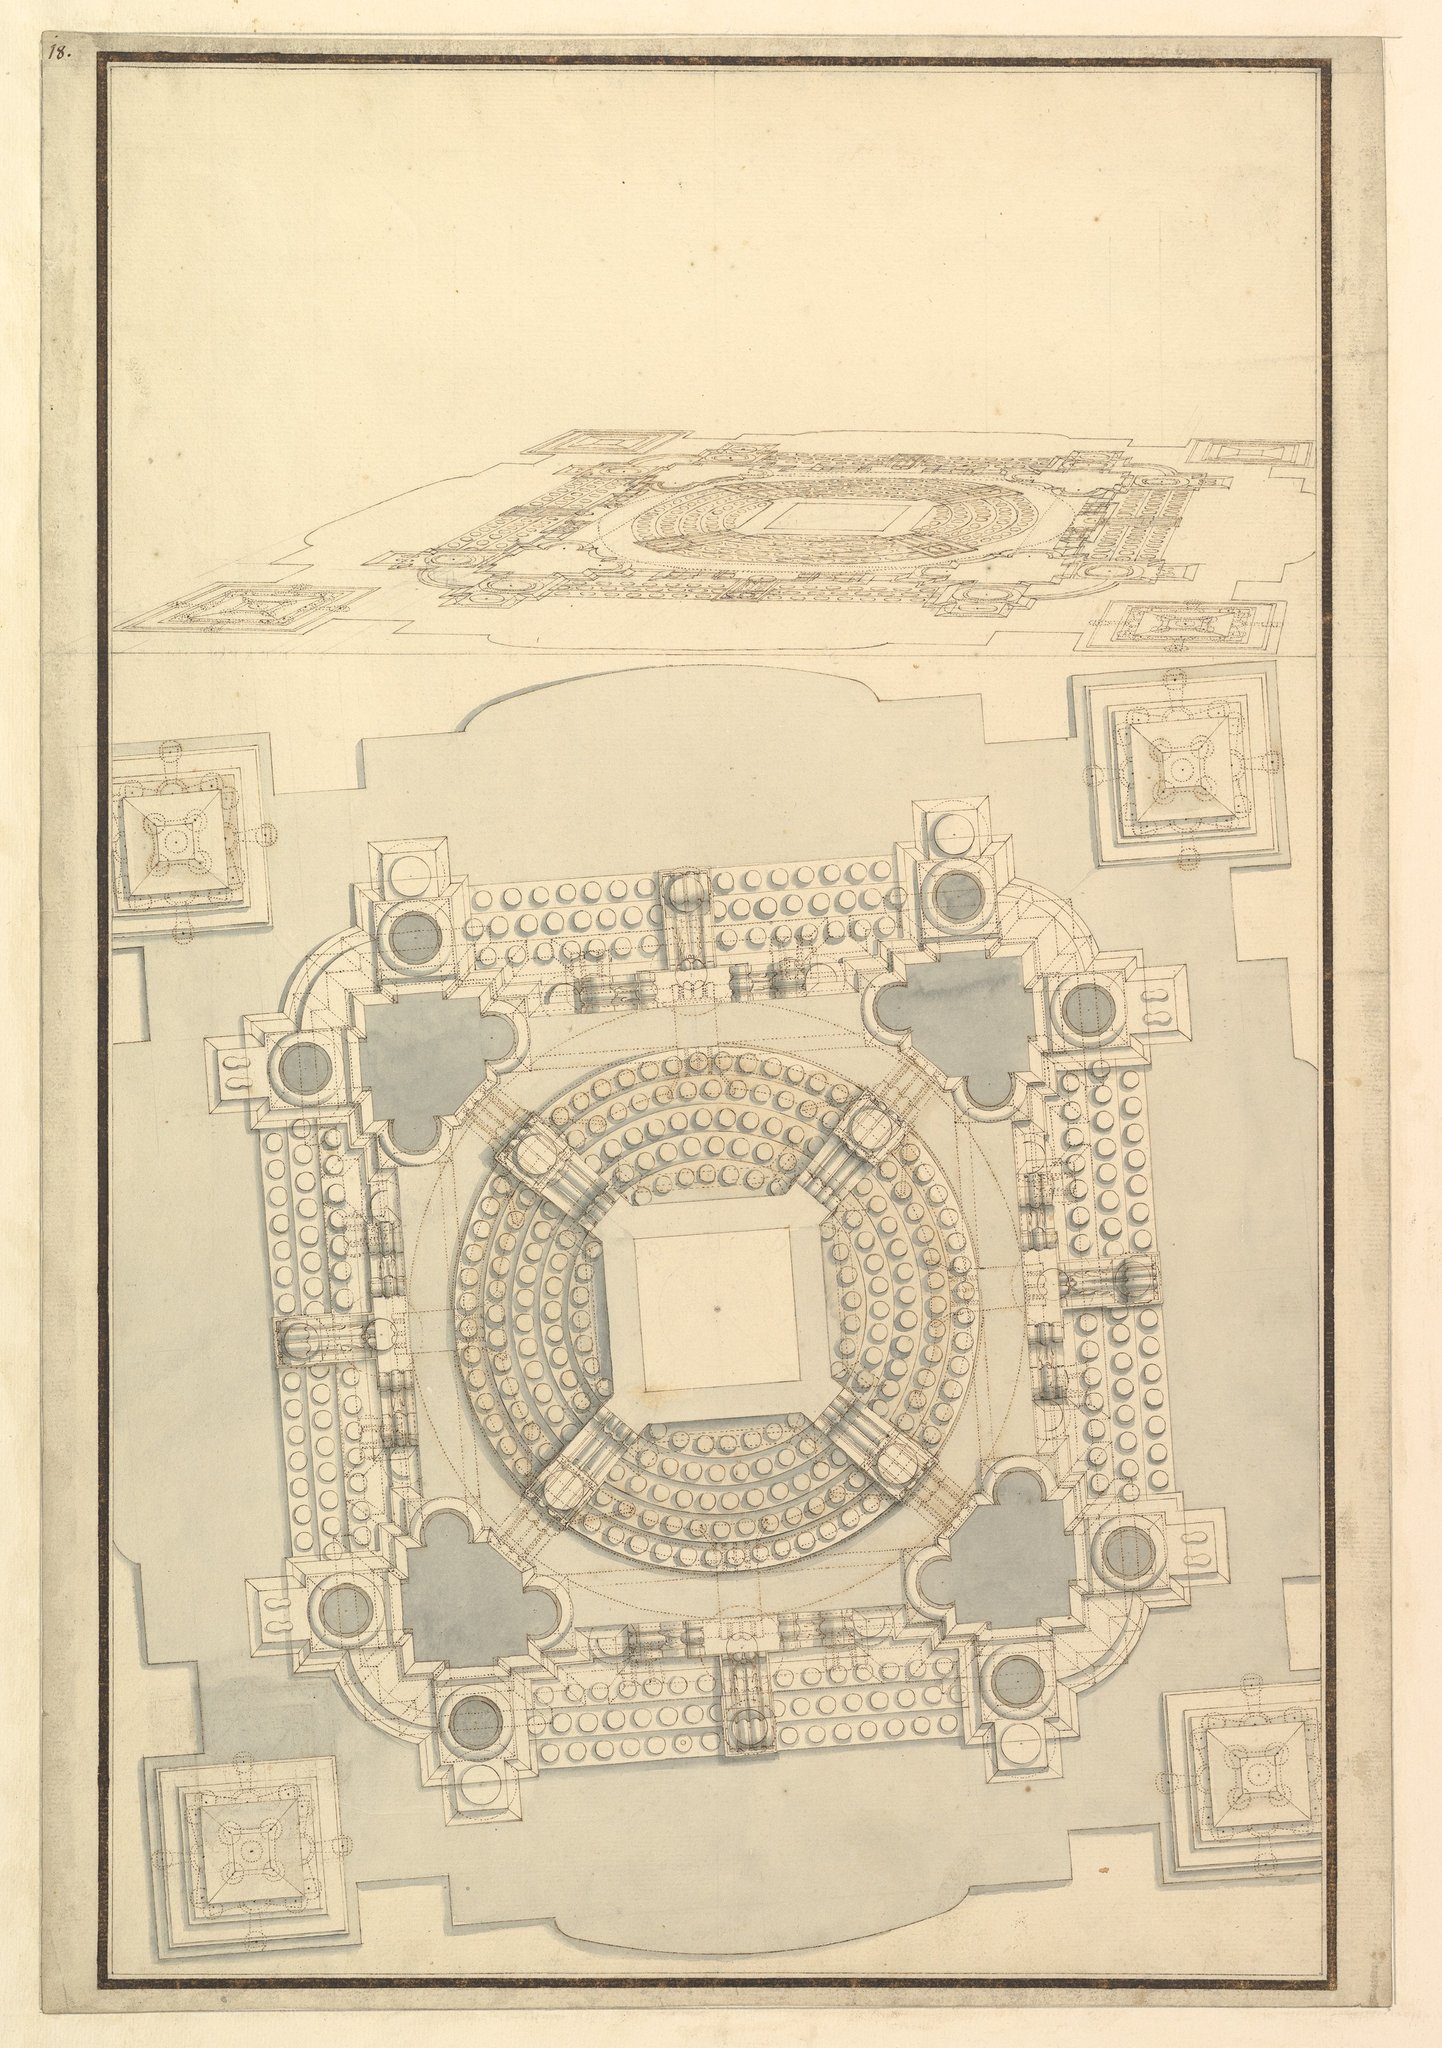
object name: drawing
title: Ground Plan of the Catafalque for Anna Cristina, Wife of Carlo Emanuele II of Savoy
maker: giuseppe galli bibiena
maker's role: artist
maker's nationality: italian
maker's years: 1696-1756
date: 1696-1756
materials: ink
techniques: brush, pen, wash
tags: architecture